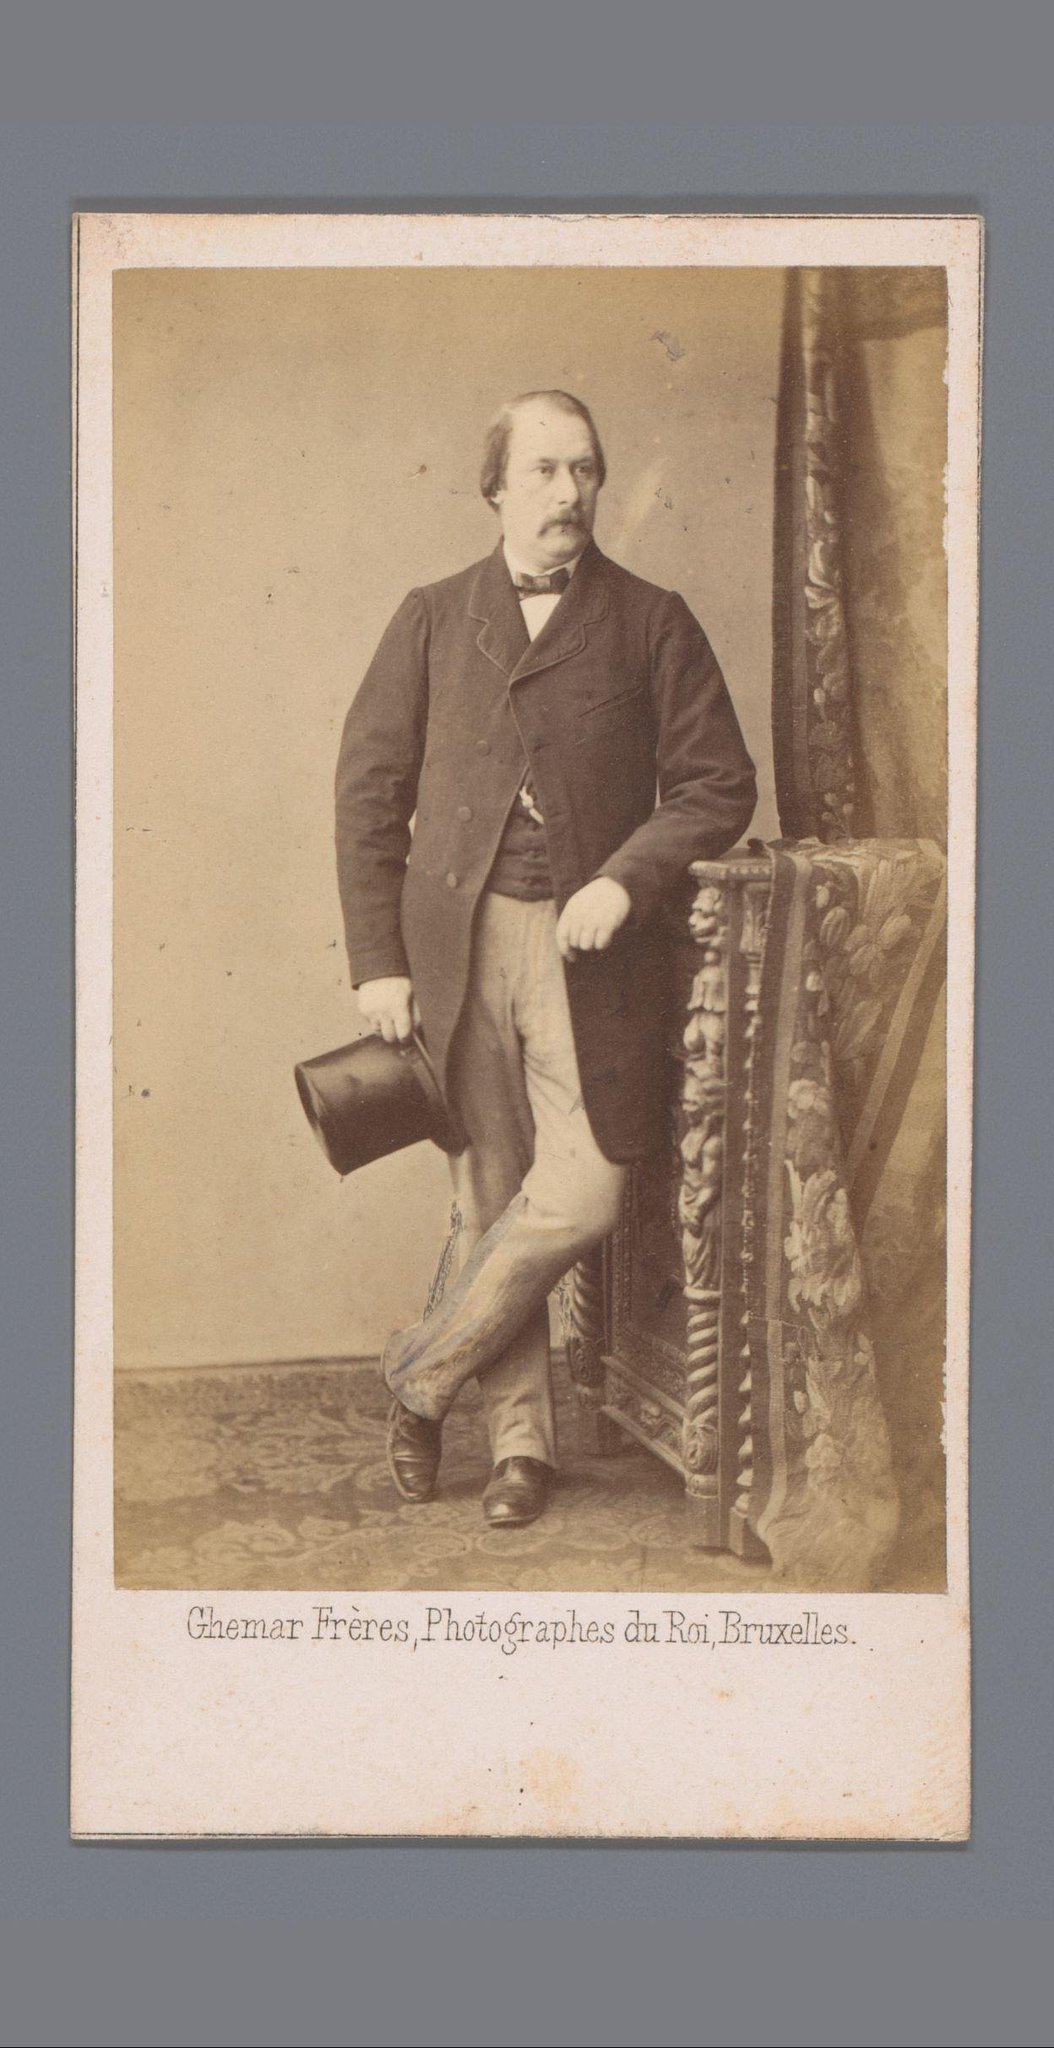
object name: photograph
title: Portret van een onbekende man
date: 1859-1894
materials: cardboard, paper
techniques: albumen print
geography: brussels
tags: adult man, anonymous historical person portrayed, head-gear: top hat, brussels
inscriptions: inscription: ‘Ghemar Frères, Photographes du Roi, Bruxelles’, inscription: ‘Atelier de photographie./ Ghémar Frères,/ Photographes du roi,/ 27, Rue de l'Ecuyer,/ entrée par la porte cochère,/ Bruxelles.’